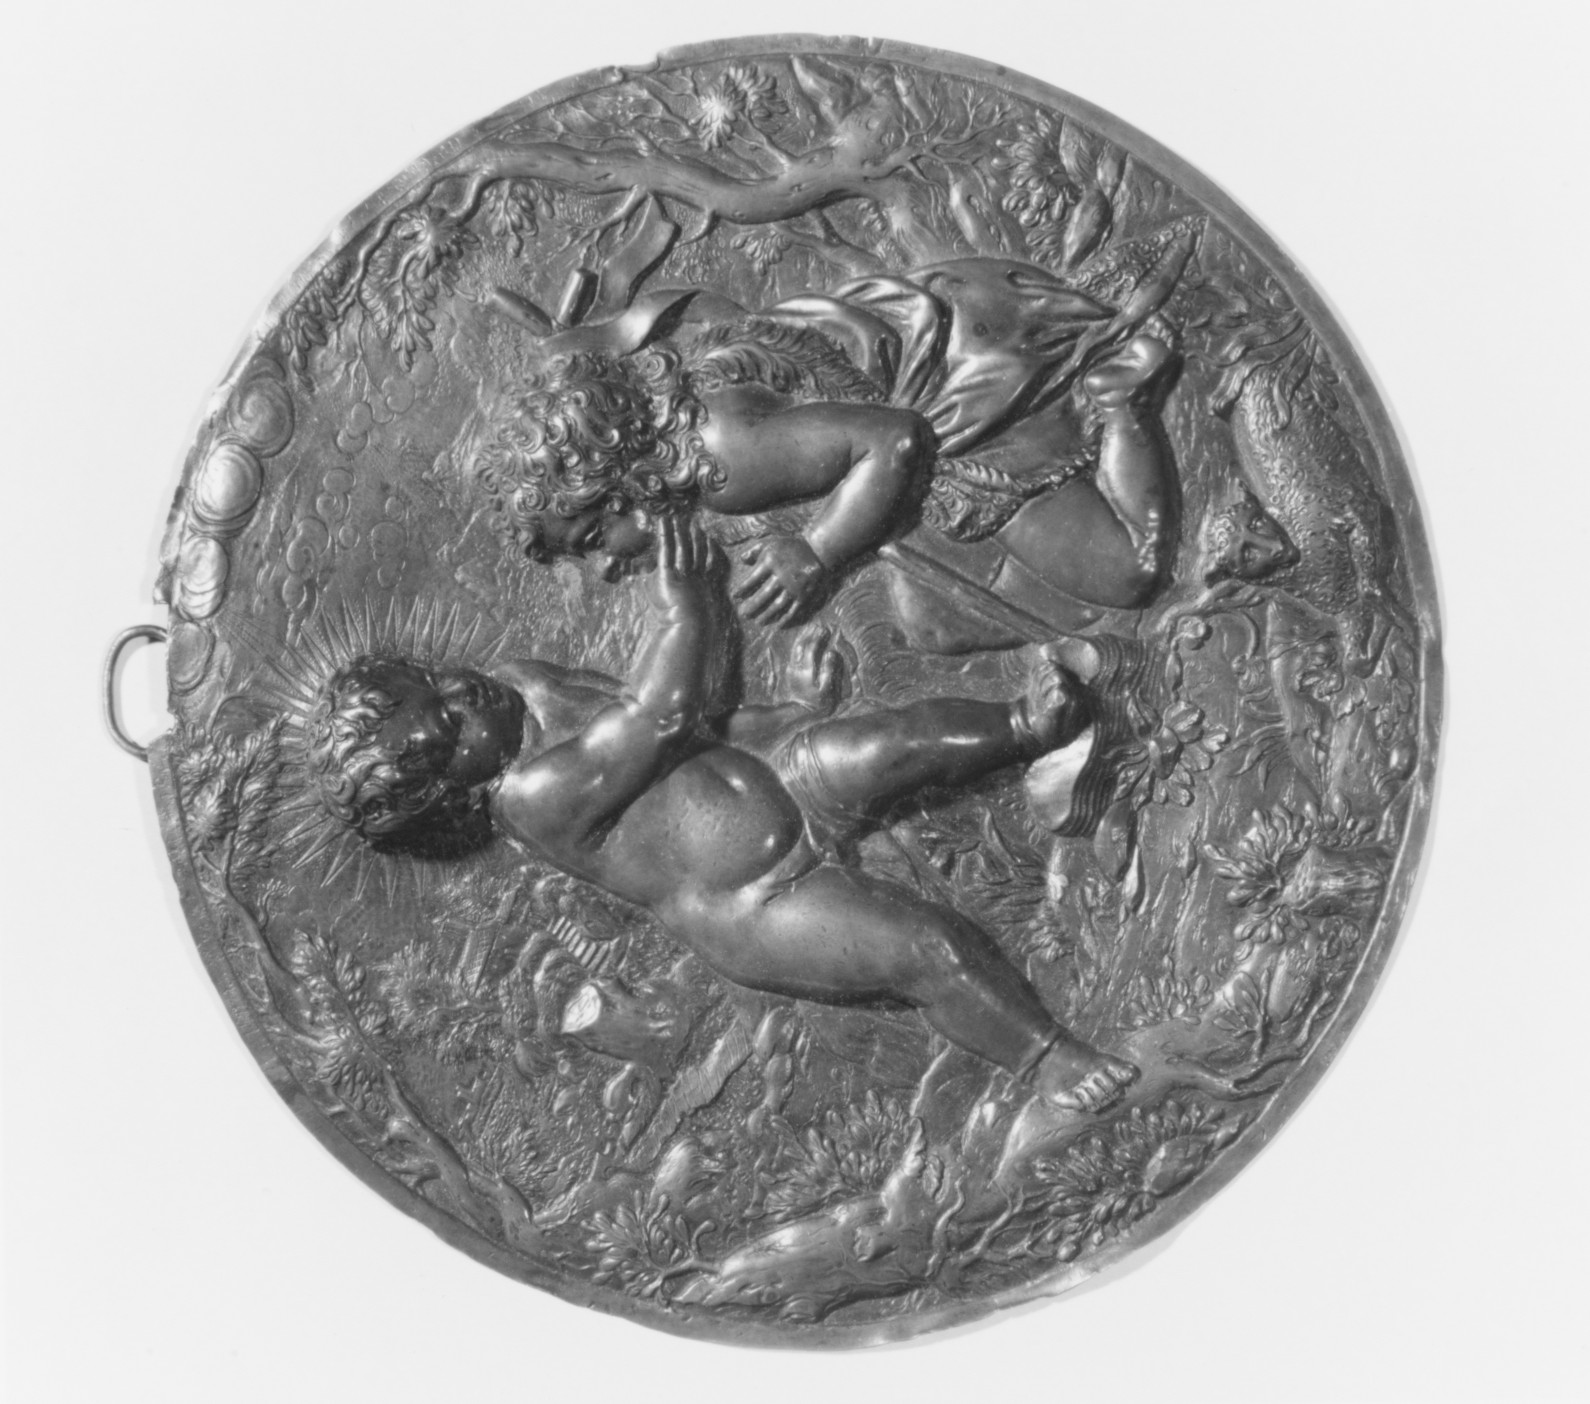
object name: plaquette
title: Infant Christ and Young St. John the Baptist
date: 1601-1700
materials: bronze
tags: christ,saint john the baptist